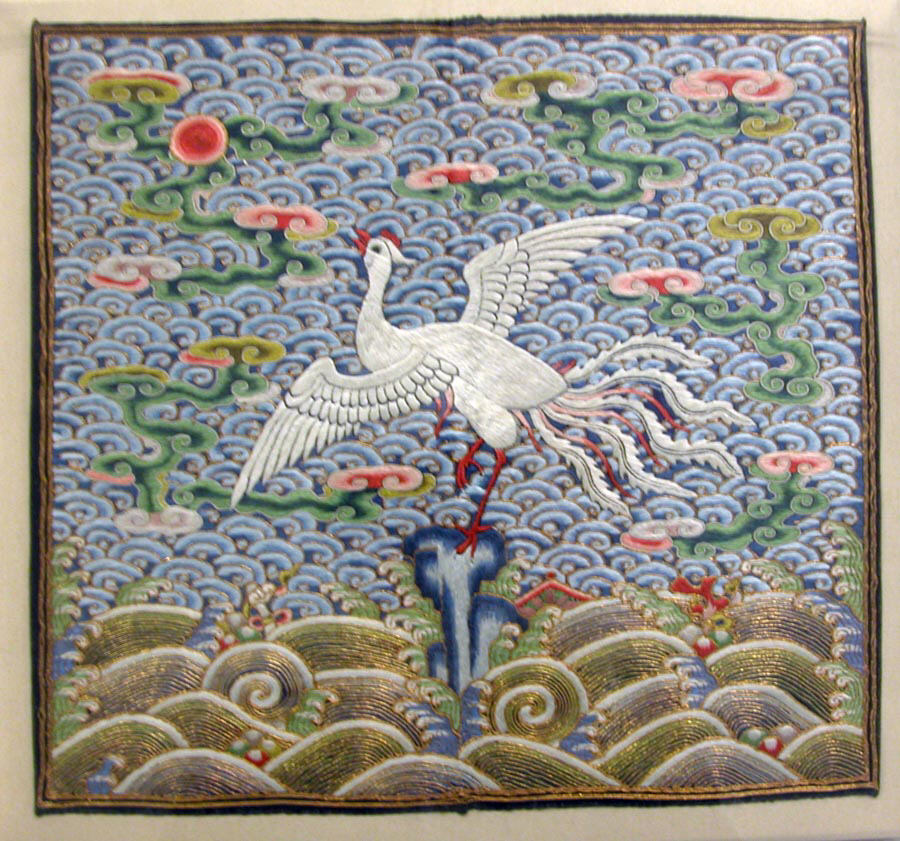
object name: rank badge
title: Rank Badge with Silver Pheasant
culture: chinese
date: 1701-1833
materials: metal thread, silk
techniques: embroidery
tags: pheasants